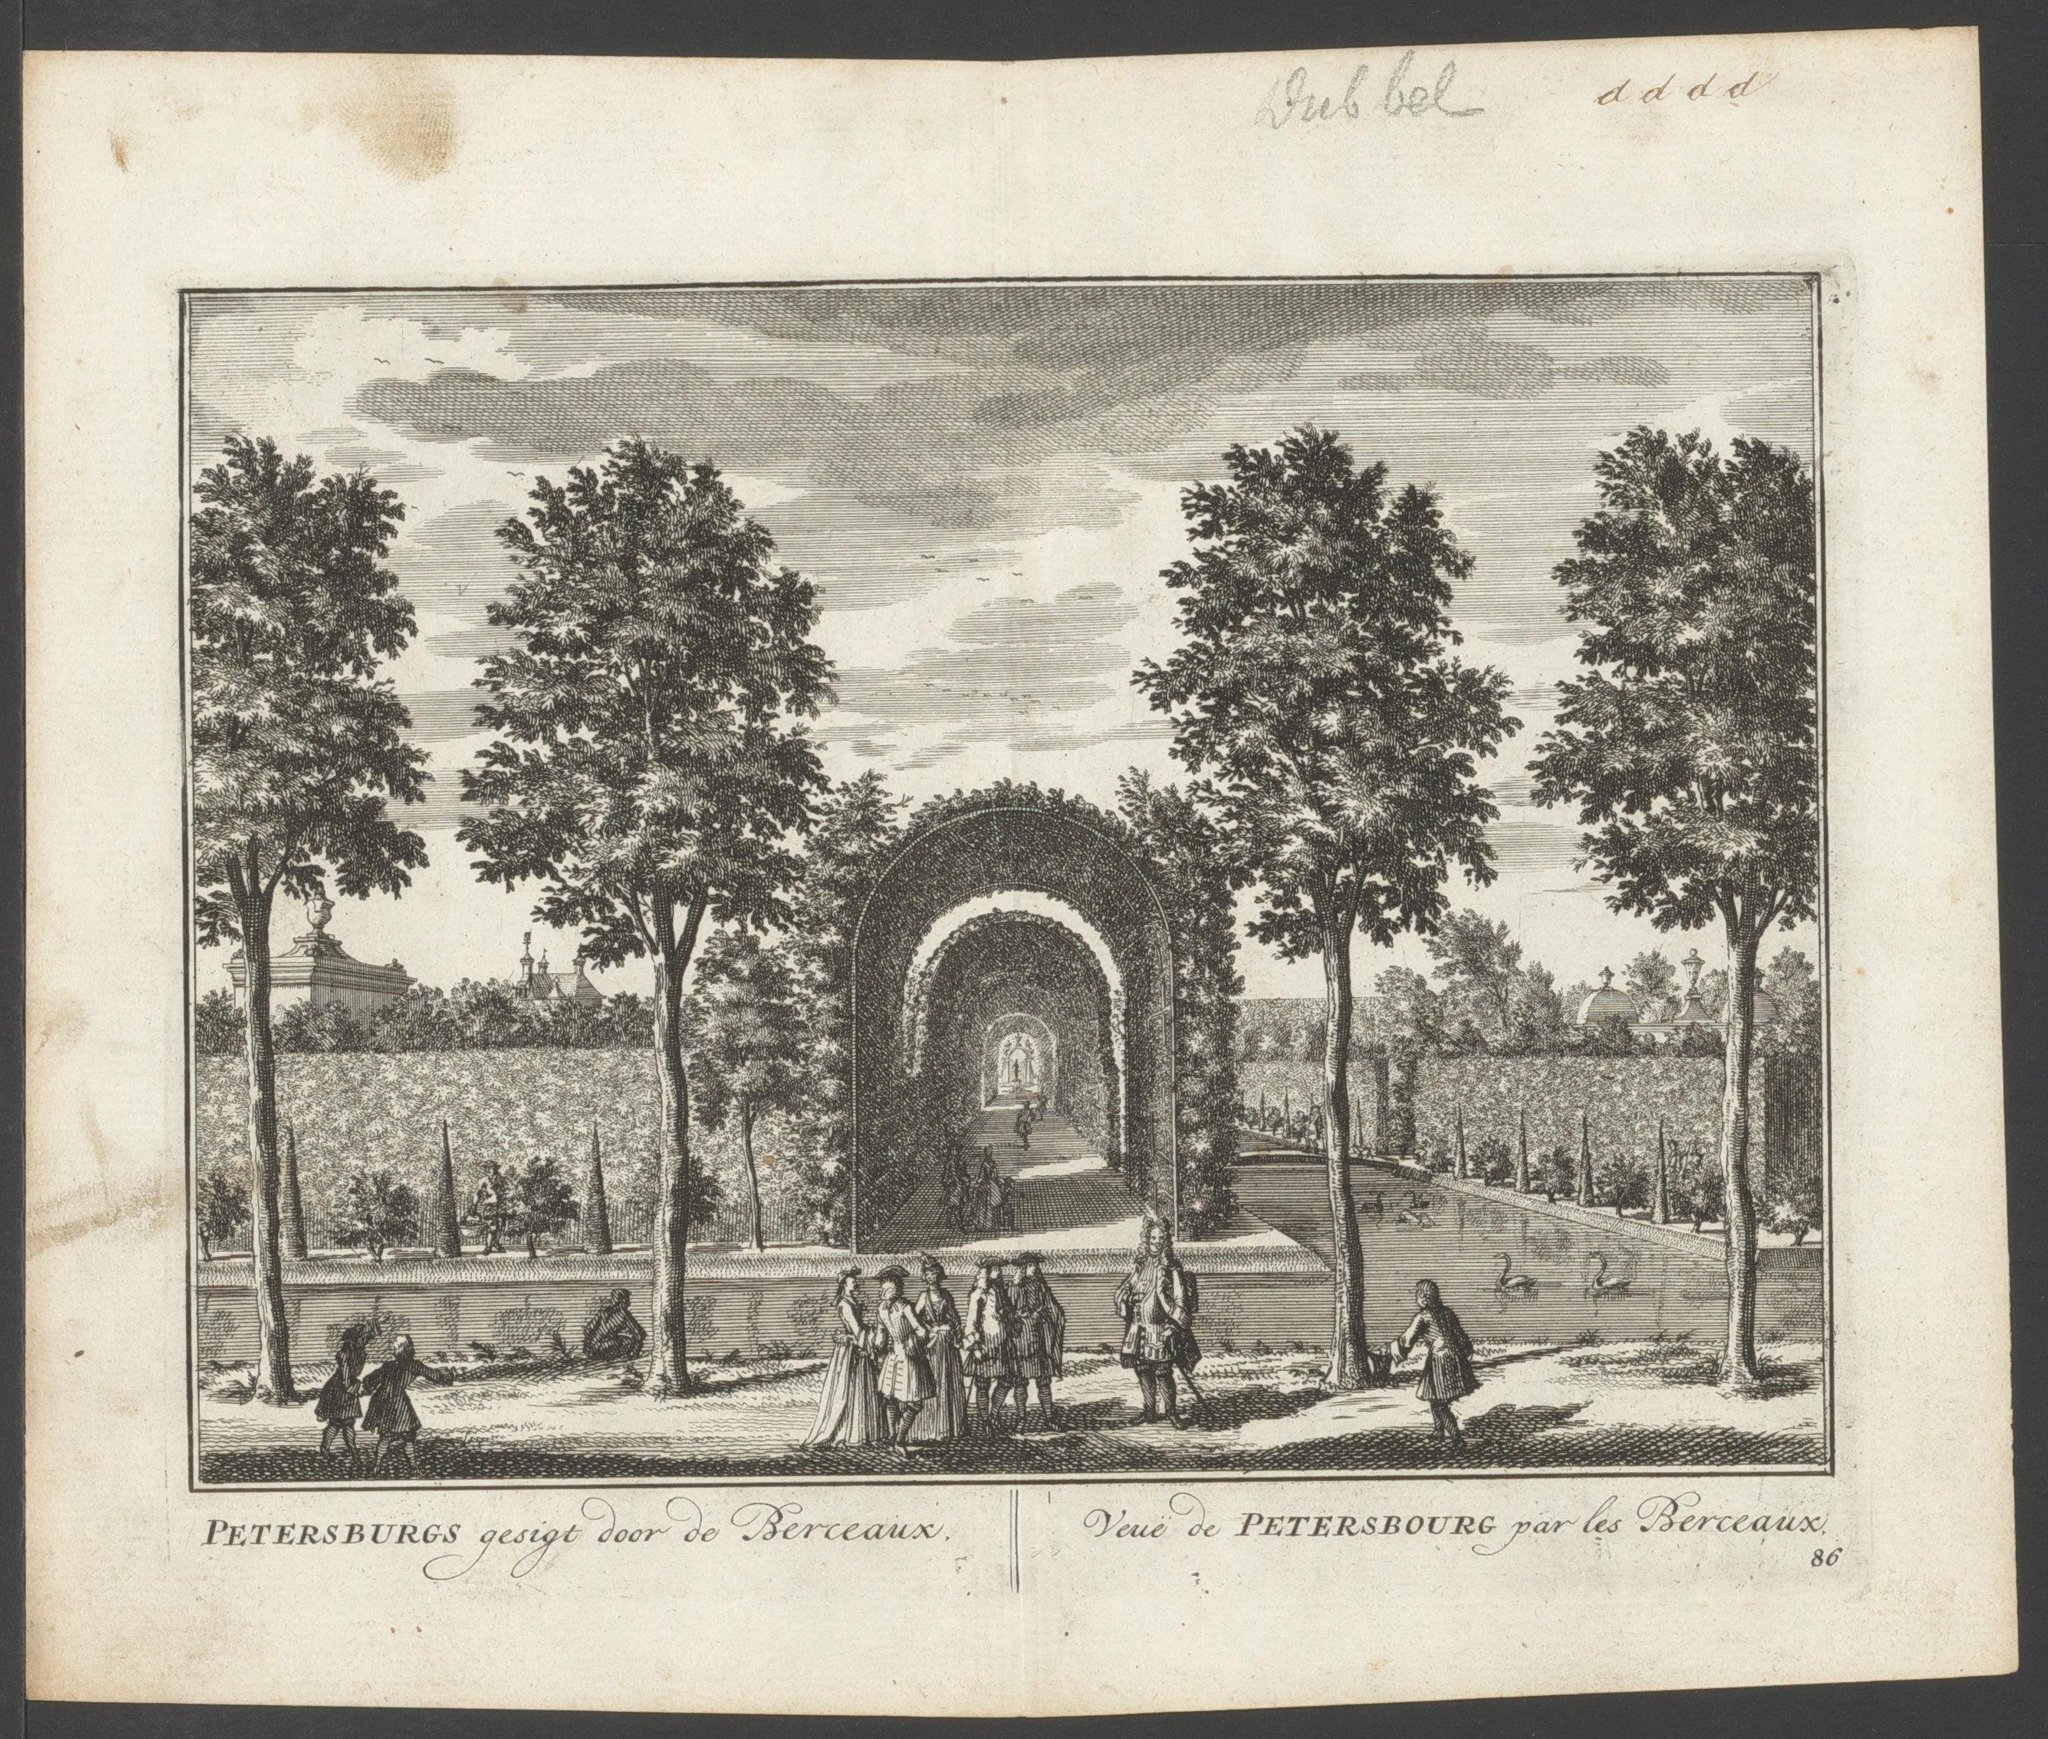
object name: print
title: Gezicht op de pergola in de tuin van de buitenplaats Petersburg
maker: daniël stopendaal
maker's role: print maker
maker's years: 1672-1726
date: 1790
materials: paper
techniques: engraving, etching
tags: french or architectonic garden; formal garden, pergola, nederhorst den berg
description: Prent voor het eerst gebruikt in: Leth, Andries de. De zegepraalende Vecht, vertoonende verscheidene gesichten van lustplaatsen, heeren huysen en dorpen, beginnende van Uitrecht en met Muyden besluytende (...). Amsterdam: Weduwe Nicolaus Visscher, 1719. Prent mogelijk uit: Brouërius van Nidek, Matthaeus. De Vechtstroom, van Utrecht tot Muiden (...). Amsterdam: H. Gartman, W. Vermandel en J.W. Smit, 1790.